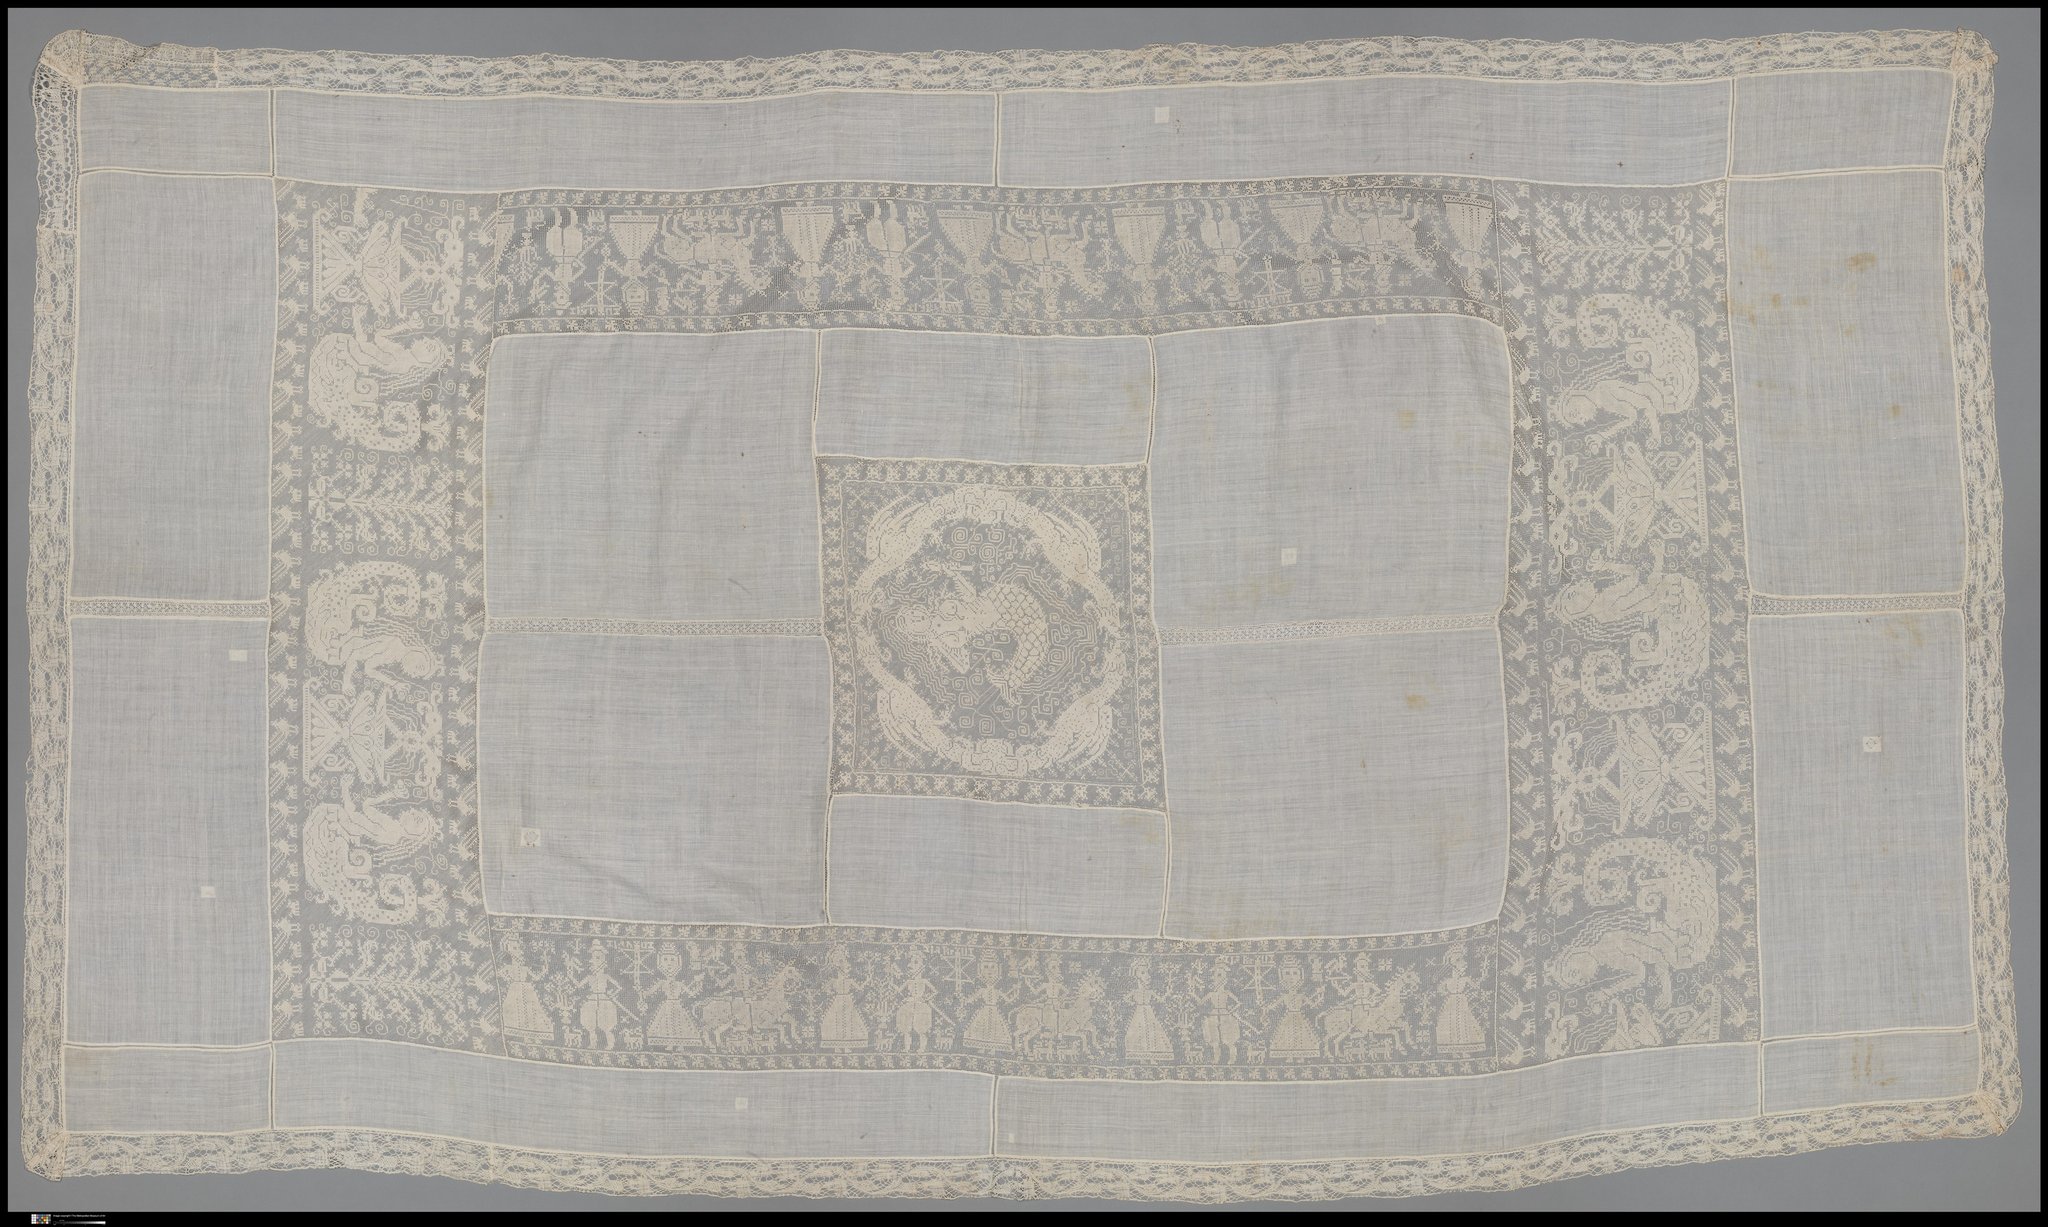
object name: cover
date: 1501-1600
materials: linen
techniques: embroidery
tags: human figures,mermaids,horses